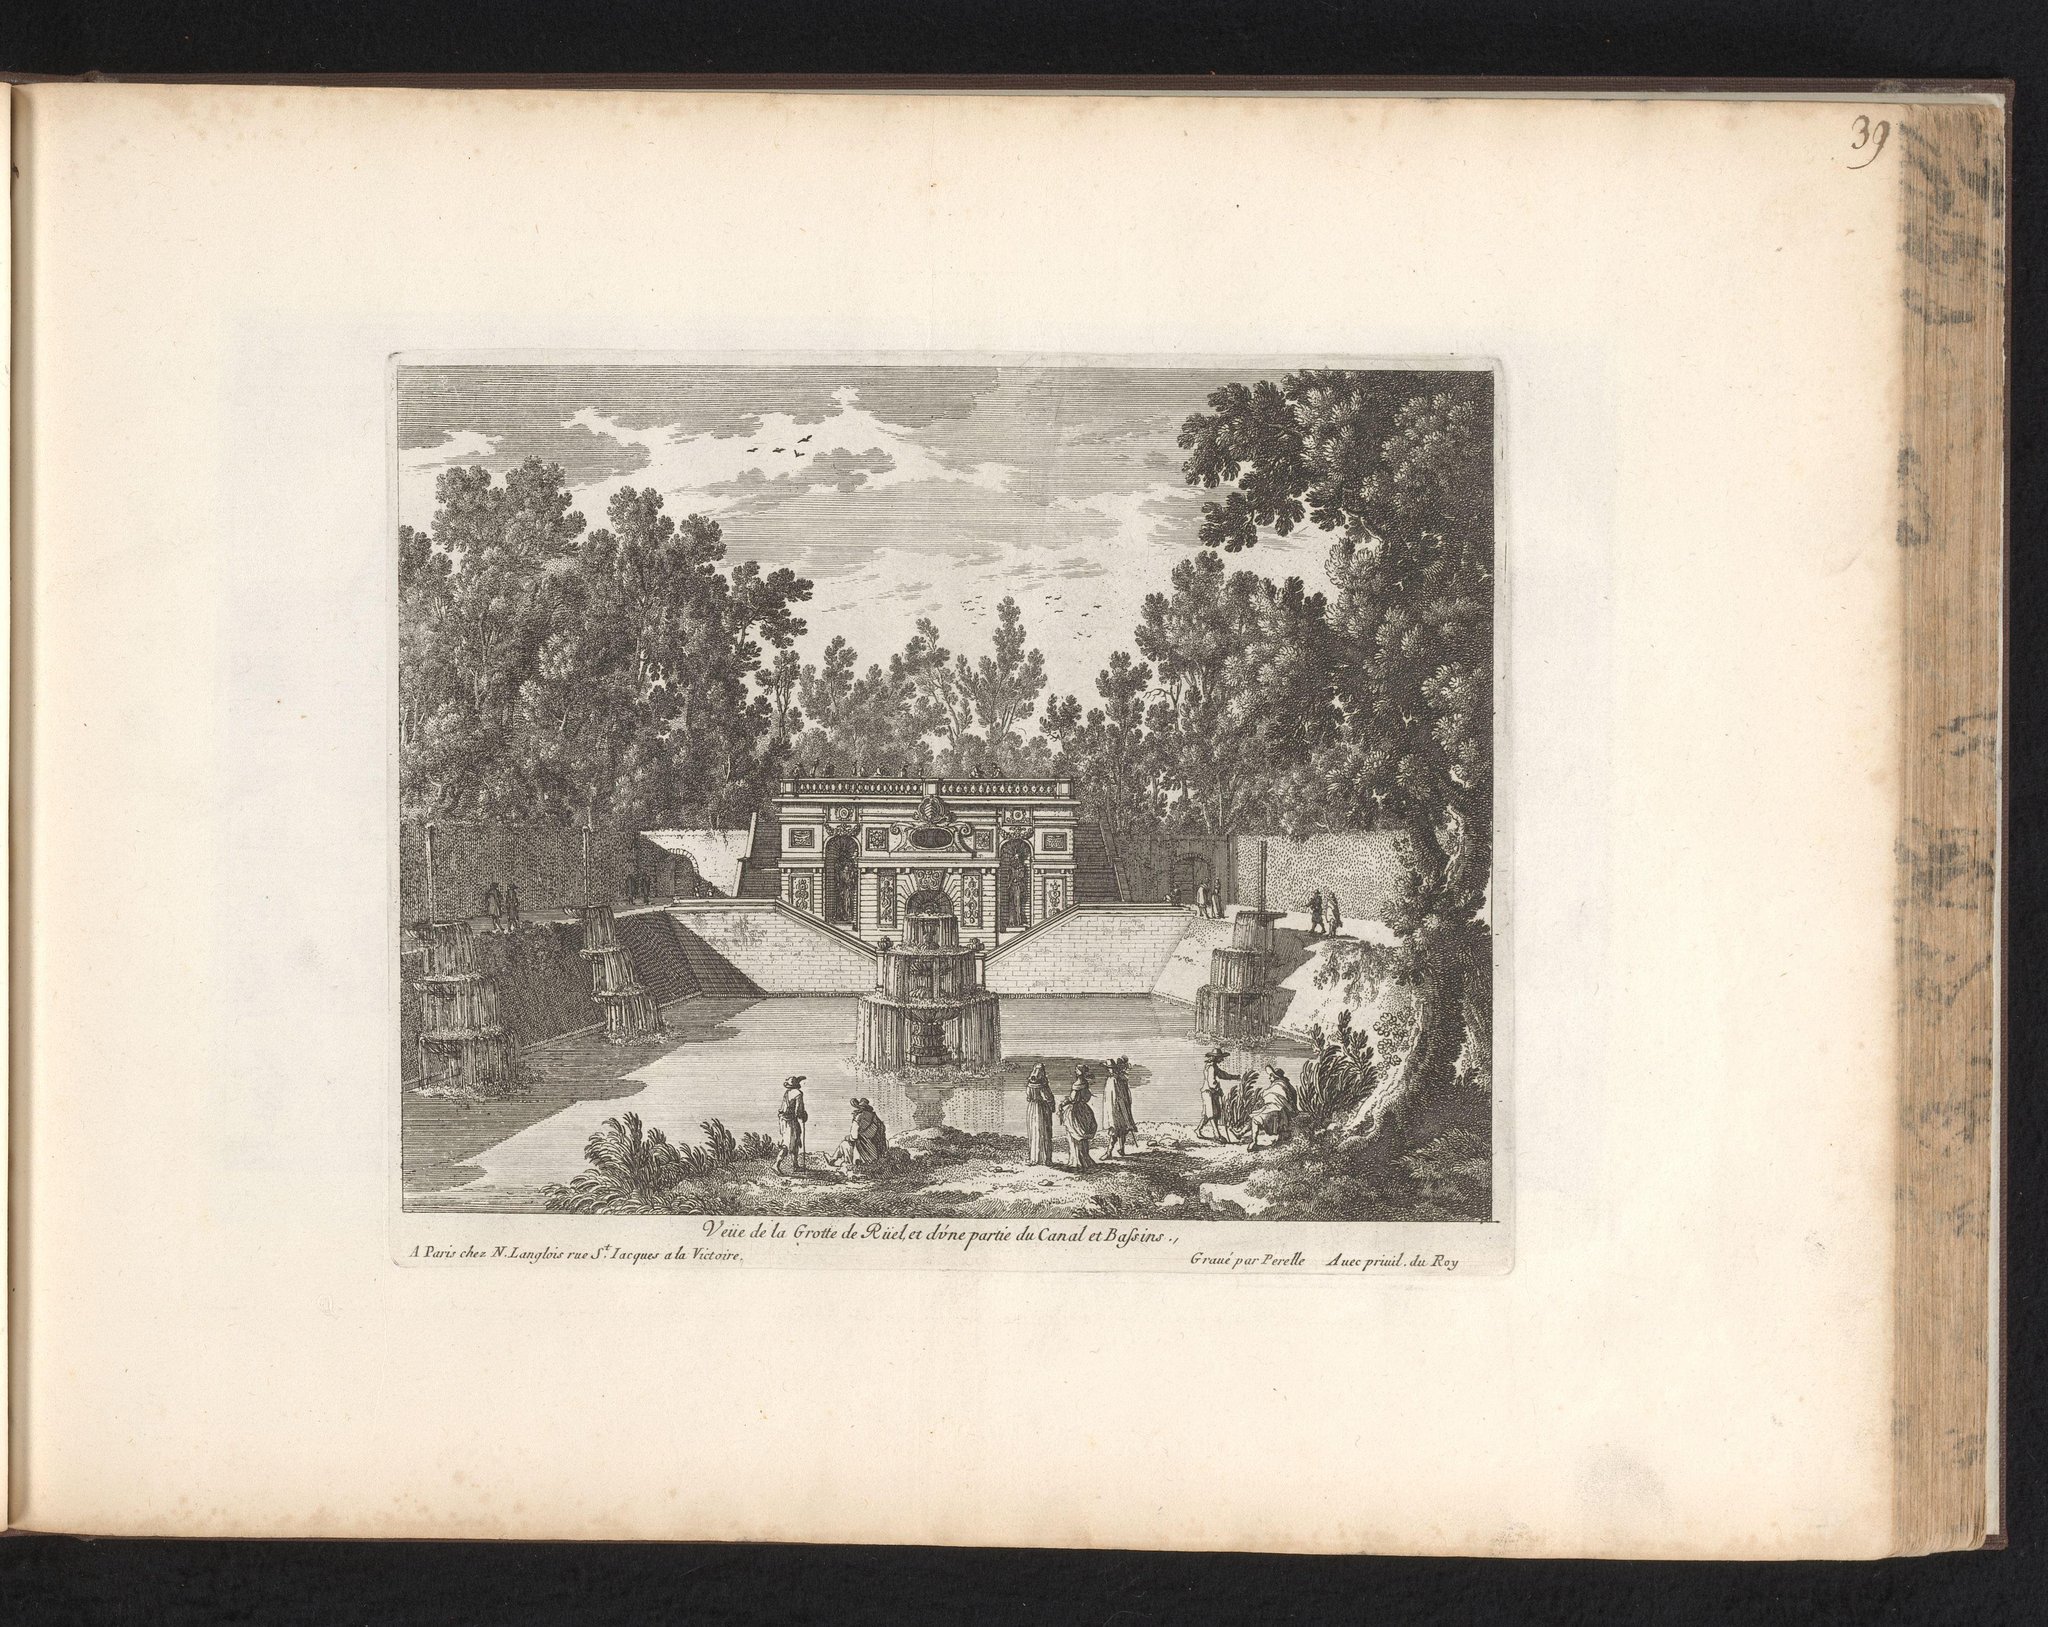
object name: print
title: Stadsgezichten en landschappen in Frankrijk en Italië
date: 1613-1707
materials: paper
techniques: etching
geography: paris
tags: french or architectonic garden; formal garden, landscape with tower or castle, artificial grotto in garden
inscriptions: collector's mark: Lugt 2228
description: Prenten met het signatuur 'Perelle' kunnen zowel door vader Gabriel als door zonen Nicolas en Adam gemaakt zijn. De uitgevers vader en zoon Nicolas Langlois worden allebei vermeld als N. Langlois op hetzelfde adres.